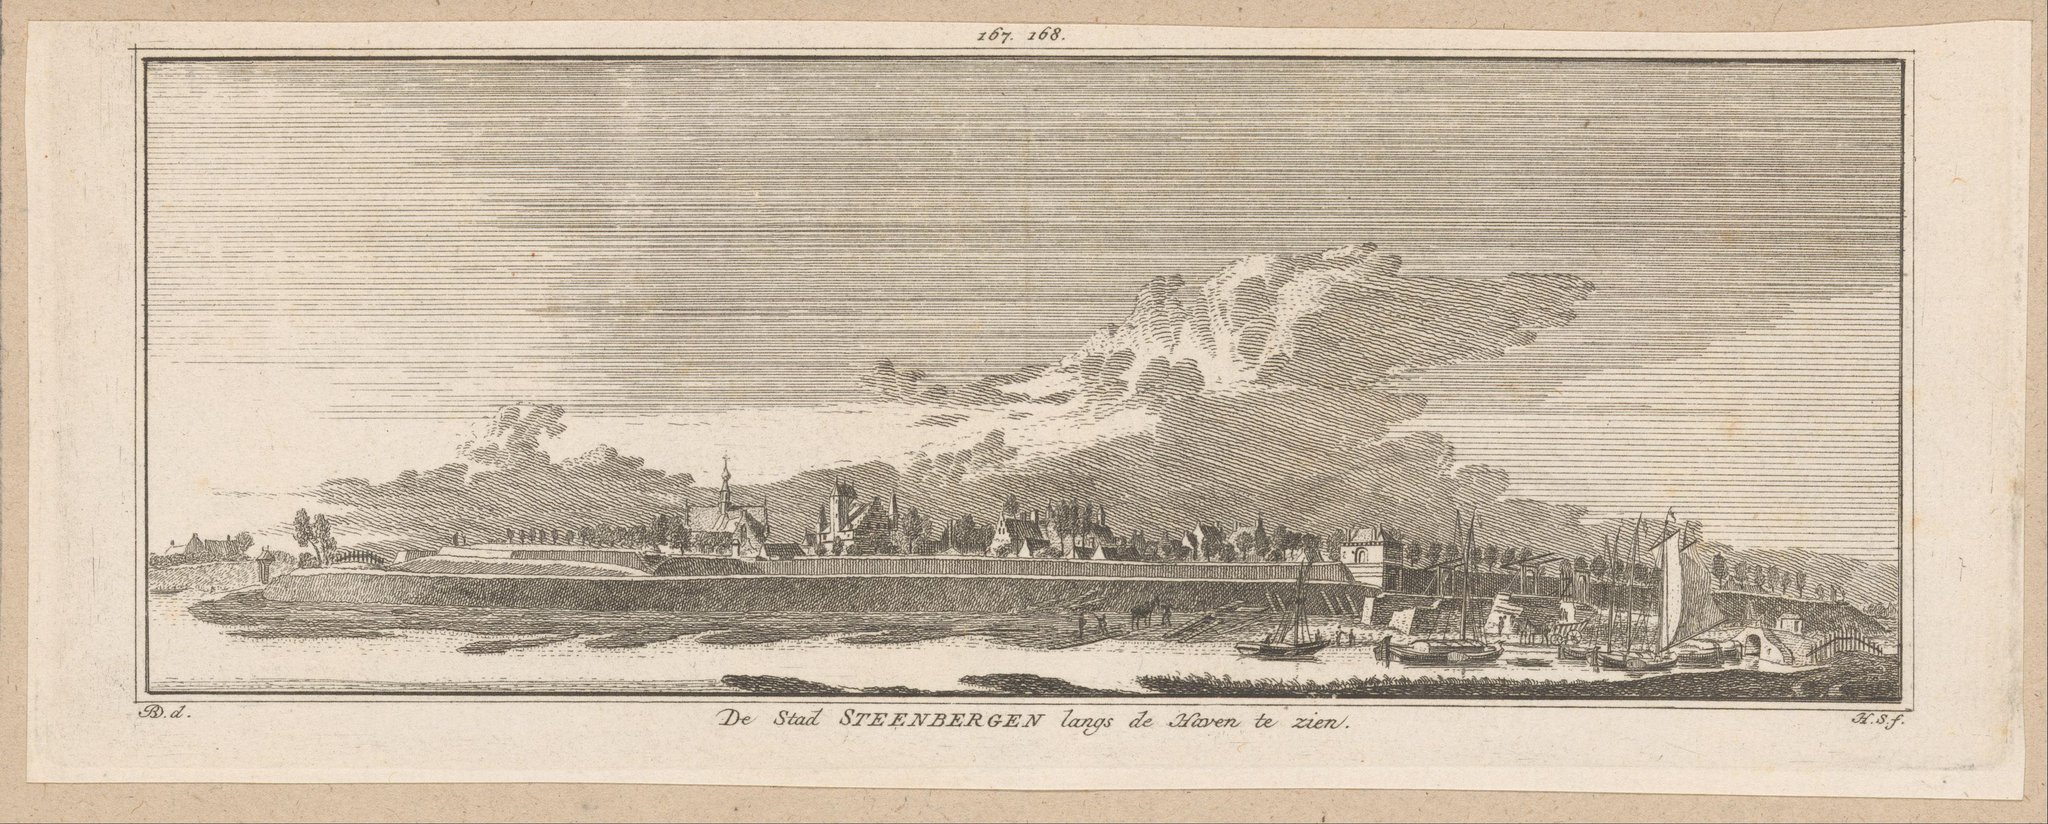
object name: print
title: Overblyfsel van een Ouden Toren te Steenbergen. 1740 / Stad.Huis en Kerk te Steenbergen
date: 1746-1792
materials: paper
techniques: etching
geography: haarlem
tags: prospect of village, silhouette of village, townhall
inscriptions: collector's mark: Lugt 2228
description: Prent ook gebruikt in: Het verheerlykt Nederland of kabinet van hedendaagsche gezigten van steden, dorpen (…). 9 delen. Amsterdam: Isaak Tirion en weduwe Isaak Tirion, 1745-1774, dl. 2 (1746), ill. 169-170. Of in: Nederlandsche tafereelen; of eene keurige verzameling van negen honderd fraaije gezigten van steden, dorpen, sloten, oudheden [….]. 9 delen. Amsterdam: Jan de Groot, 1792, dl. 2, ill. 169-170.